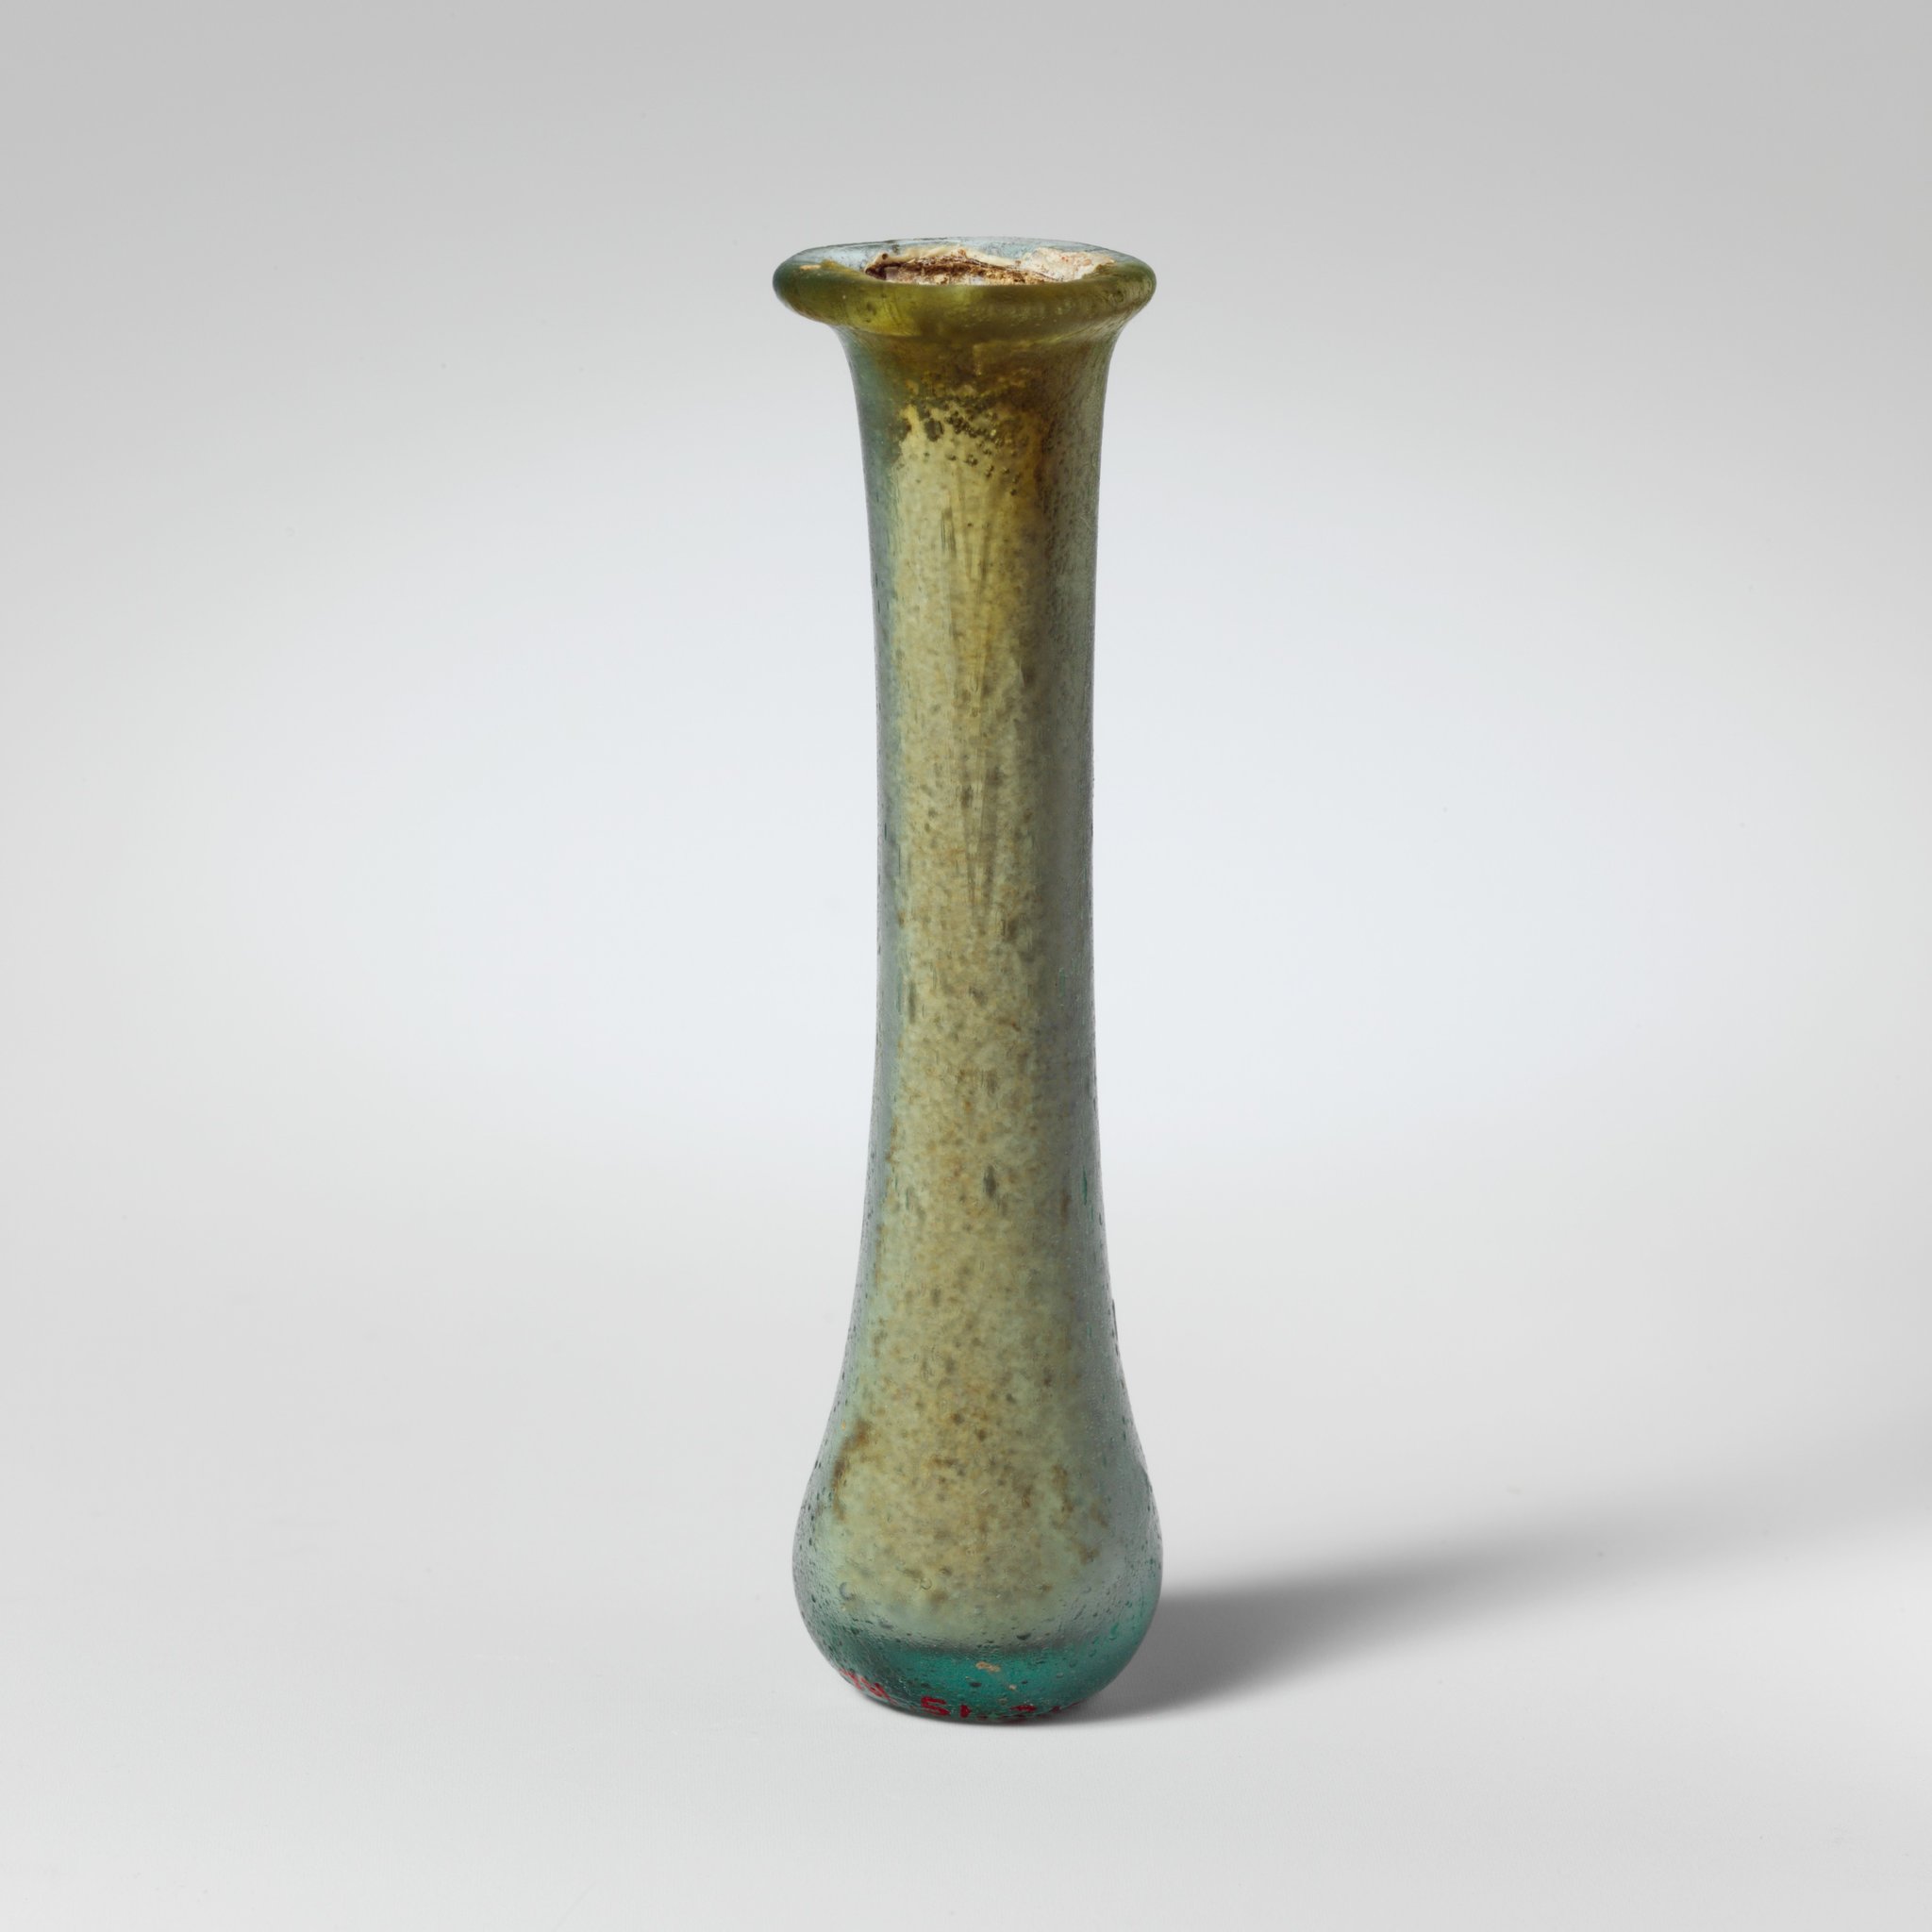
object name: perfume bottle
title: Glass perfume bottle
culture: roman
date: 101-300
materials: glass